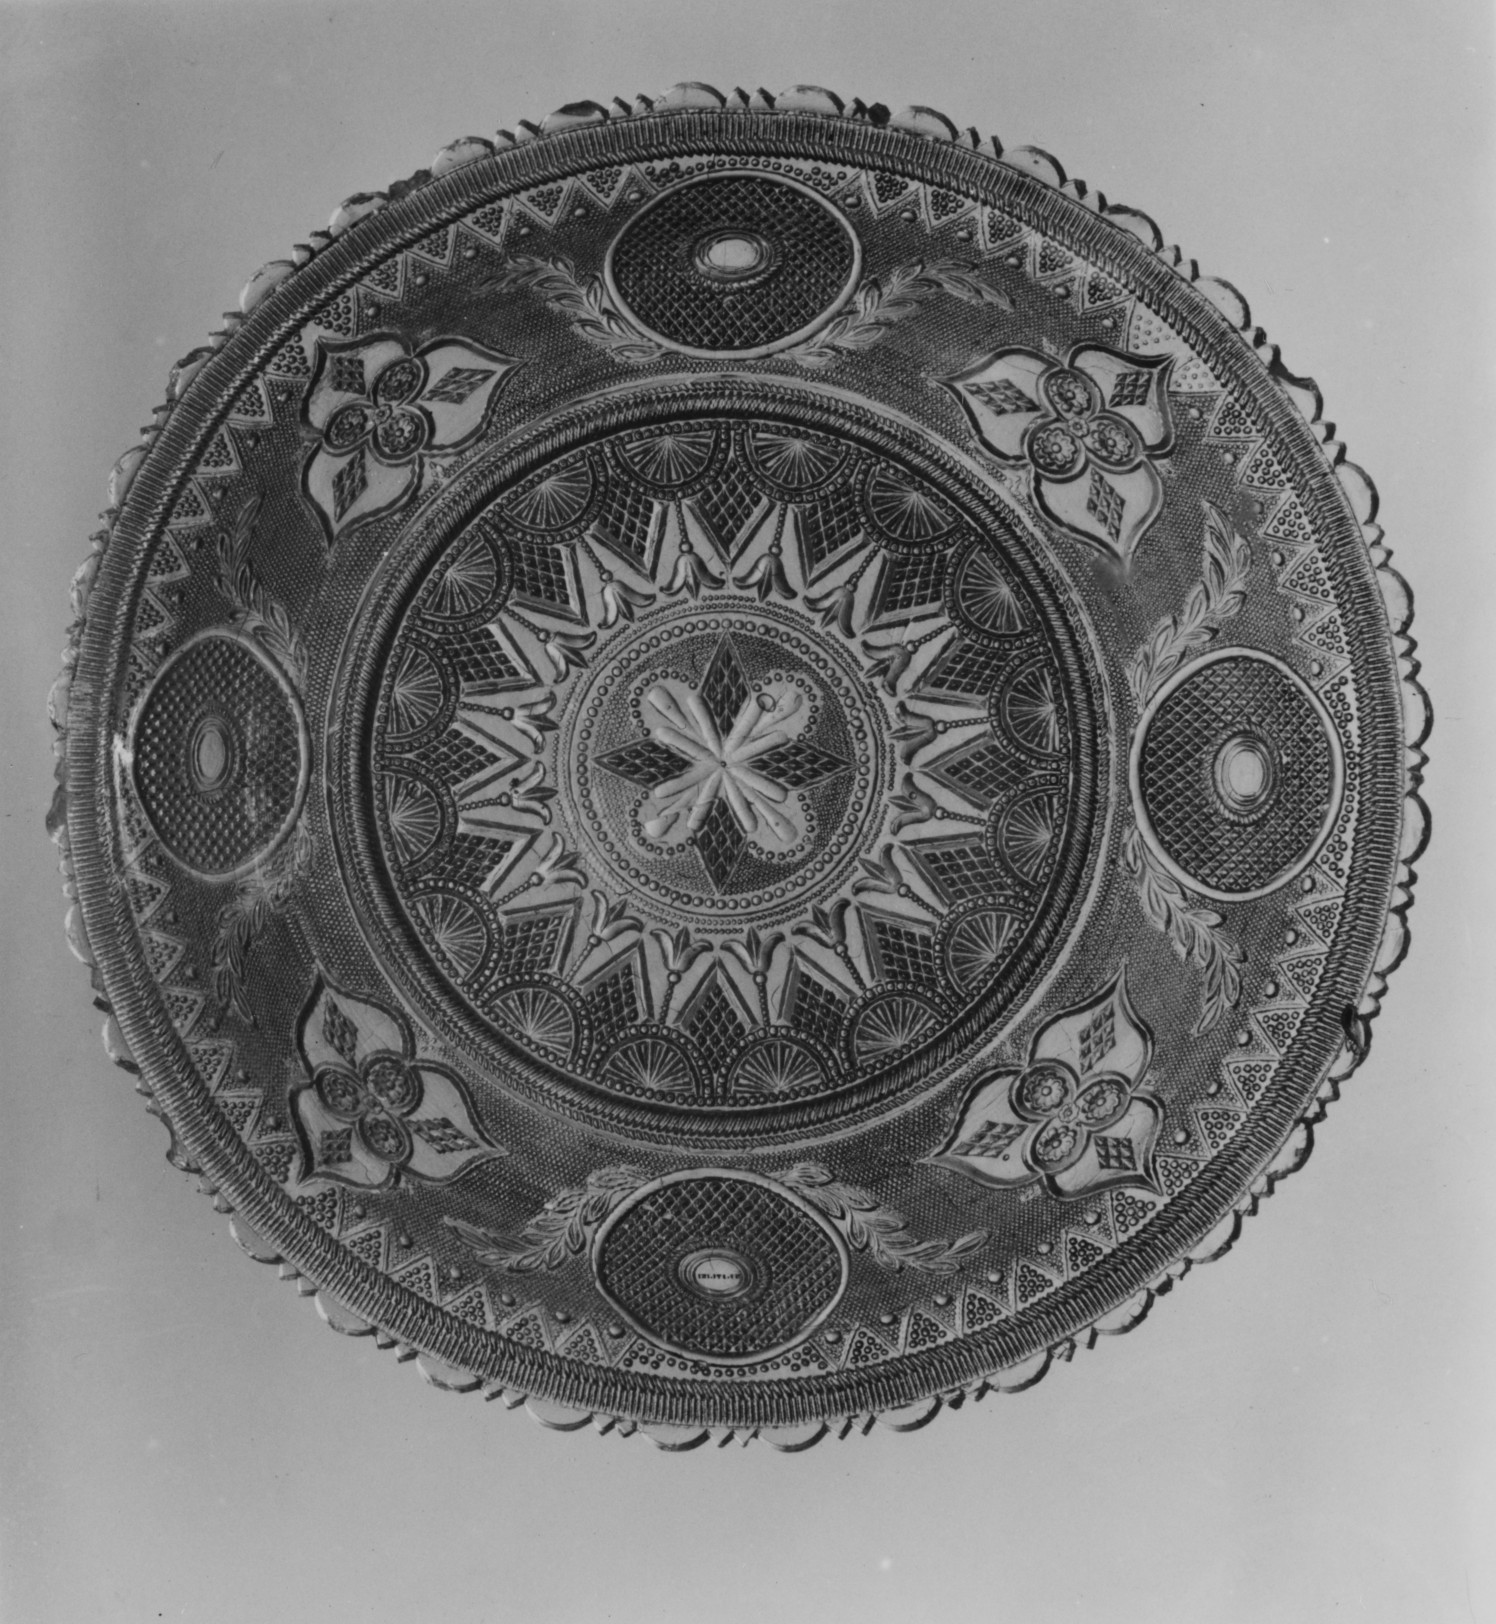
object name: bowl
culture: american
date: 1830-1840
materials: glass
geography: united states